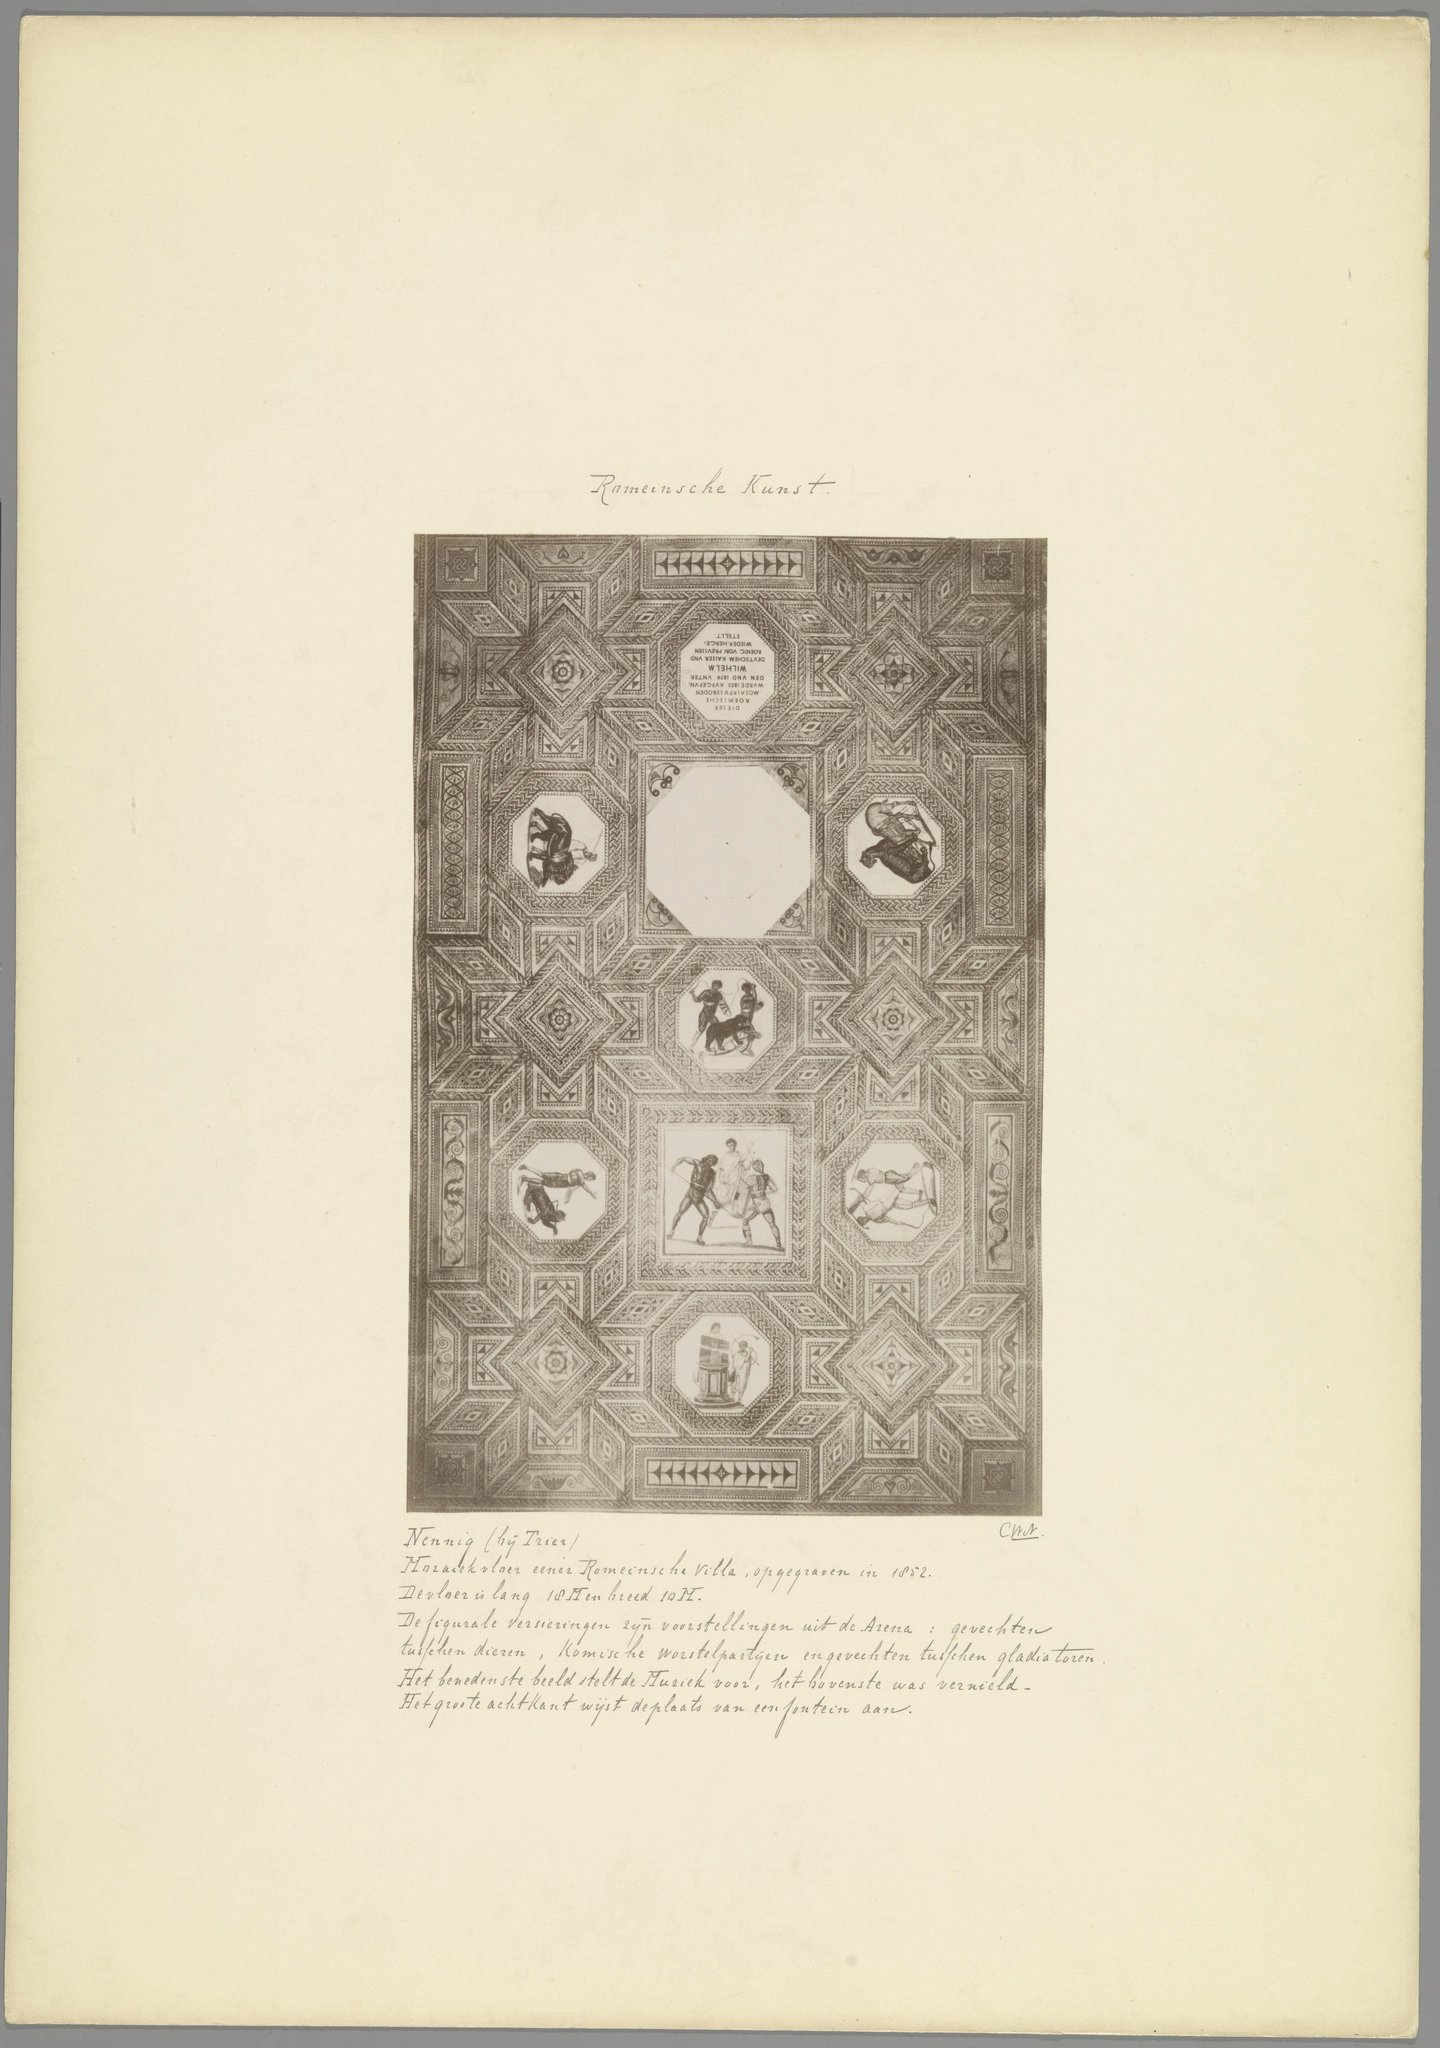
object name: photograph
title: Mozaïekvloer met voorstellingen van gevechten tussen dieren en mensen, en een personificatie van de Muziek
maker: Anonymous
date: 1875-1900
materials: cardboard, photographic support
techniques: albumen print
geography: nennig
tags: 'musica', symbolic representations, allegories and emblems ~ music; 'musica'(ripa), art (+ mosaic making), ornaments ~ art (+ surface pattern ~ ornaments), fight between animals, e.g. a lion and a bear, fight of gladiators, battle, fighting in general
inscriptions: collector's mark: ‘INSTITUUT VOOR KUNST-NIJVERHEIDSONDERWIJS GABRIËL METSUSTRAAT No. 16. AMSTERDAM’, collector's mark: ‘KUNSTNIJVERHEIDSCHOOL QUELLINUS AMSTERDAM FRANS HALSSTRAAT 14.’, inscription: ‘CWN.’, inscription: ‘Romeinsche Kunst. Nennig (bij Trier) Mozaiekvloer eener Romeische villa, opgegraven in 1852. De vloer is lang 18M en breed 10M. De figurale versieringen zijn voorstellingen uit de Arena : gevechten tusschen dieren, komische worstelpartijen en gevechten tusschen gladiatoren. Het benedenste beeld stelt de Muziek voor, het bovenste was vernield. Het groote achtkant wijst de plaats van een fontein aan.’